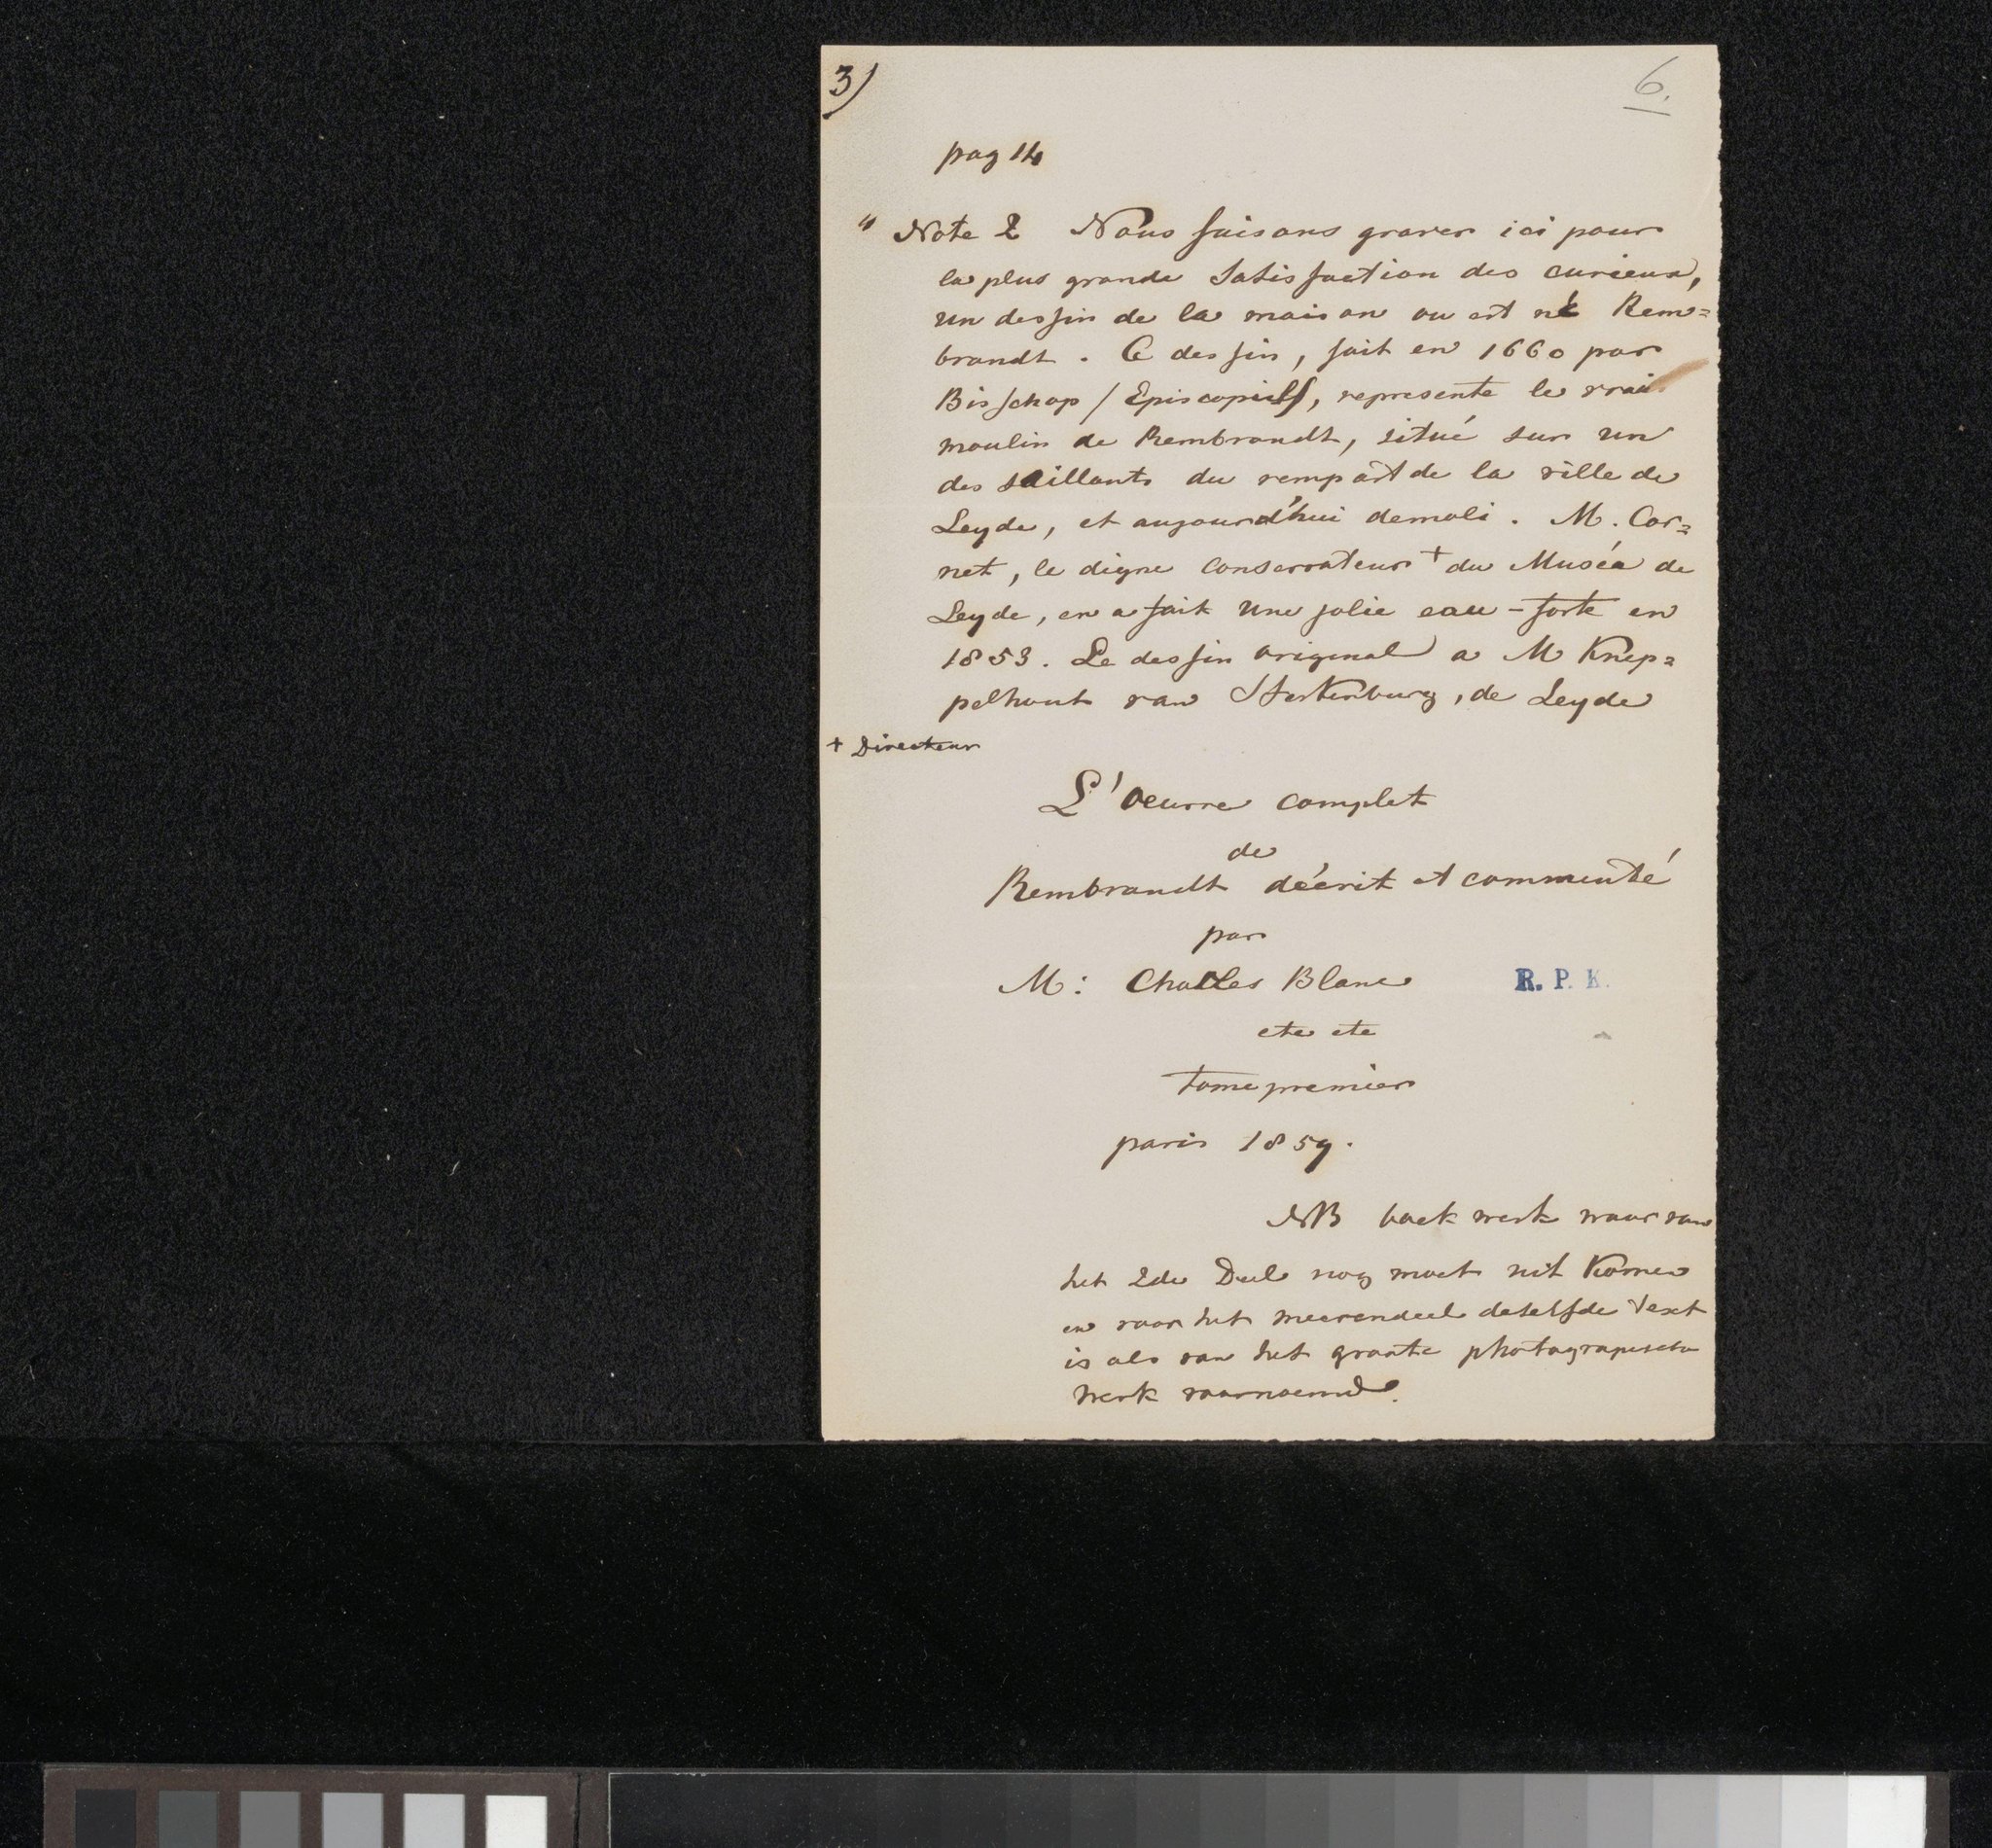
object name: aantekening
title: Aantekening betreffende Rembrandt Harmensz. van Rijn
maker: jacobus ludovicus cornet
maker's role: draughtsman, print maker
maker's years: 1815-1882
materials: ink, paper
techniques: pen, writing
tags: amsterdam, painter, rembrandt van rijn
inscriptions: collector's mark: Lugt 2233